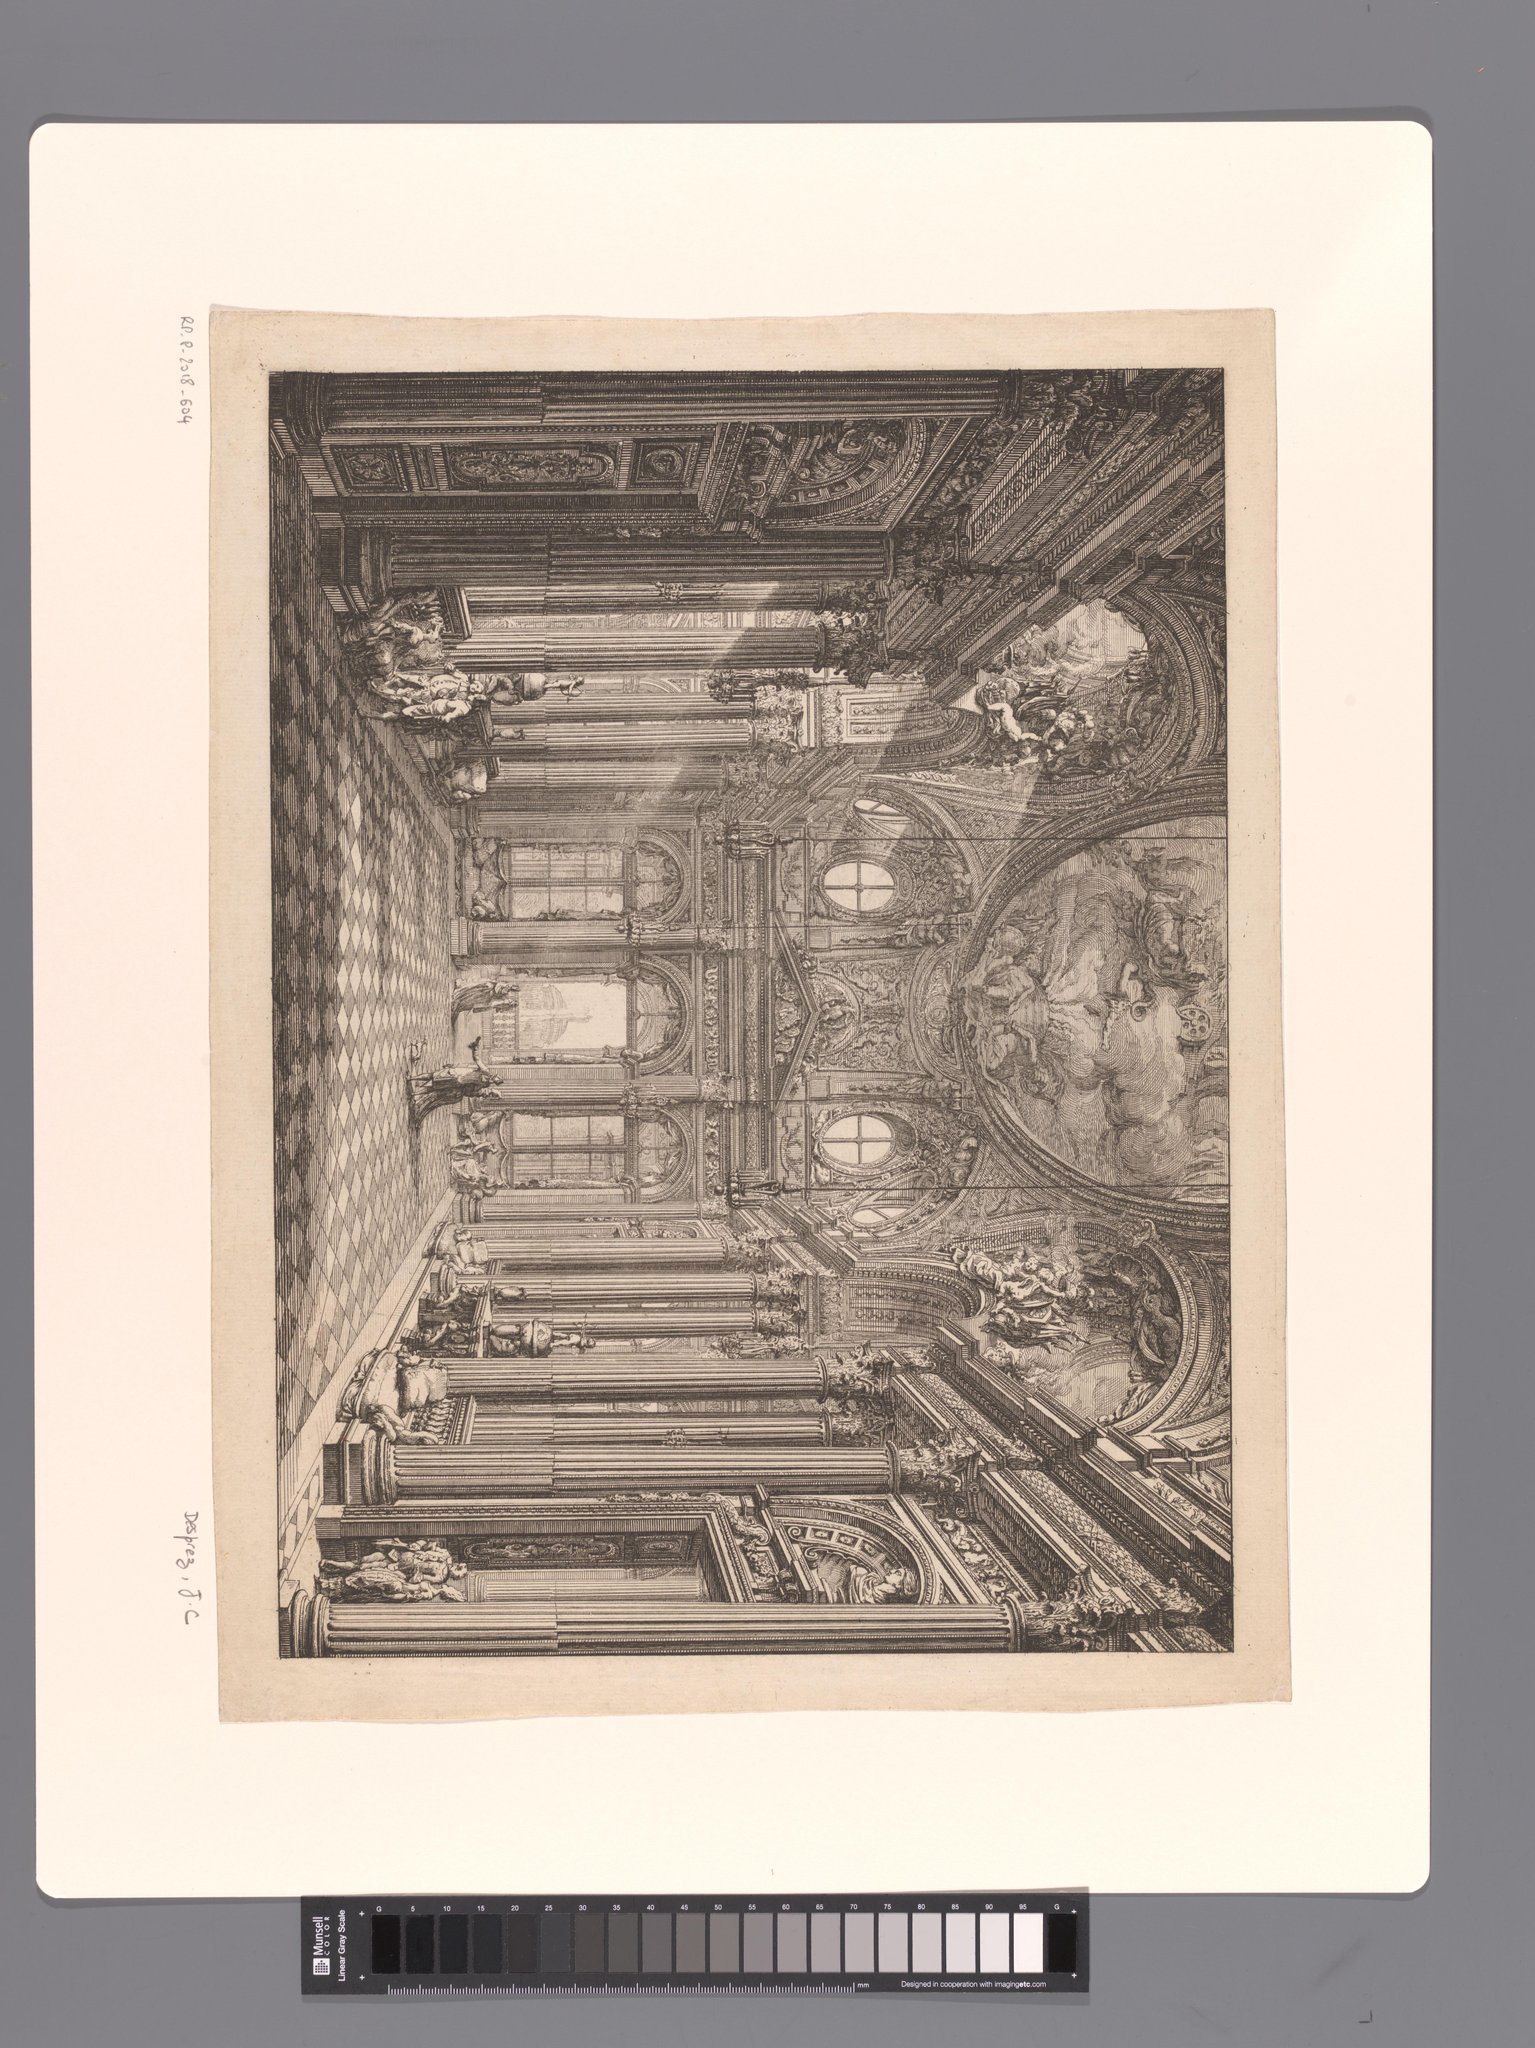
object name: print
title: Interieur van een zaal in het Palazzo Serra in Genua, met binnenvallend zonlicht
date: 1784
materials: paper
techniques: etching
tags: hôtel, i.e. small palace in city - aa - civic architecture: inside, sunbeams